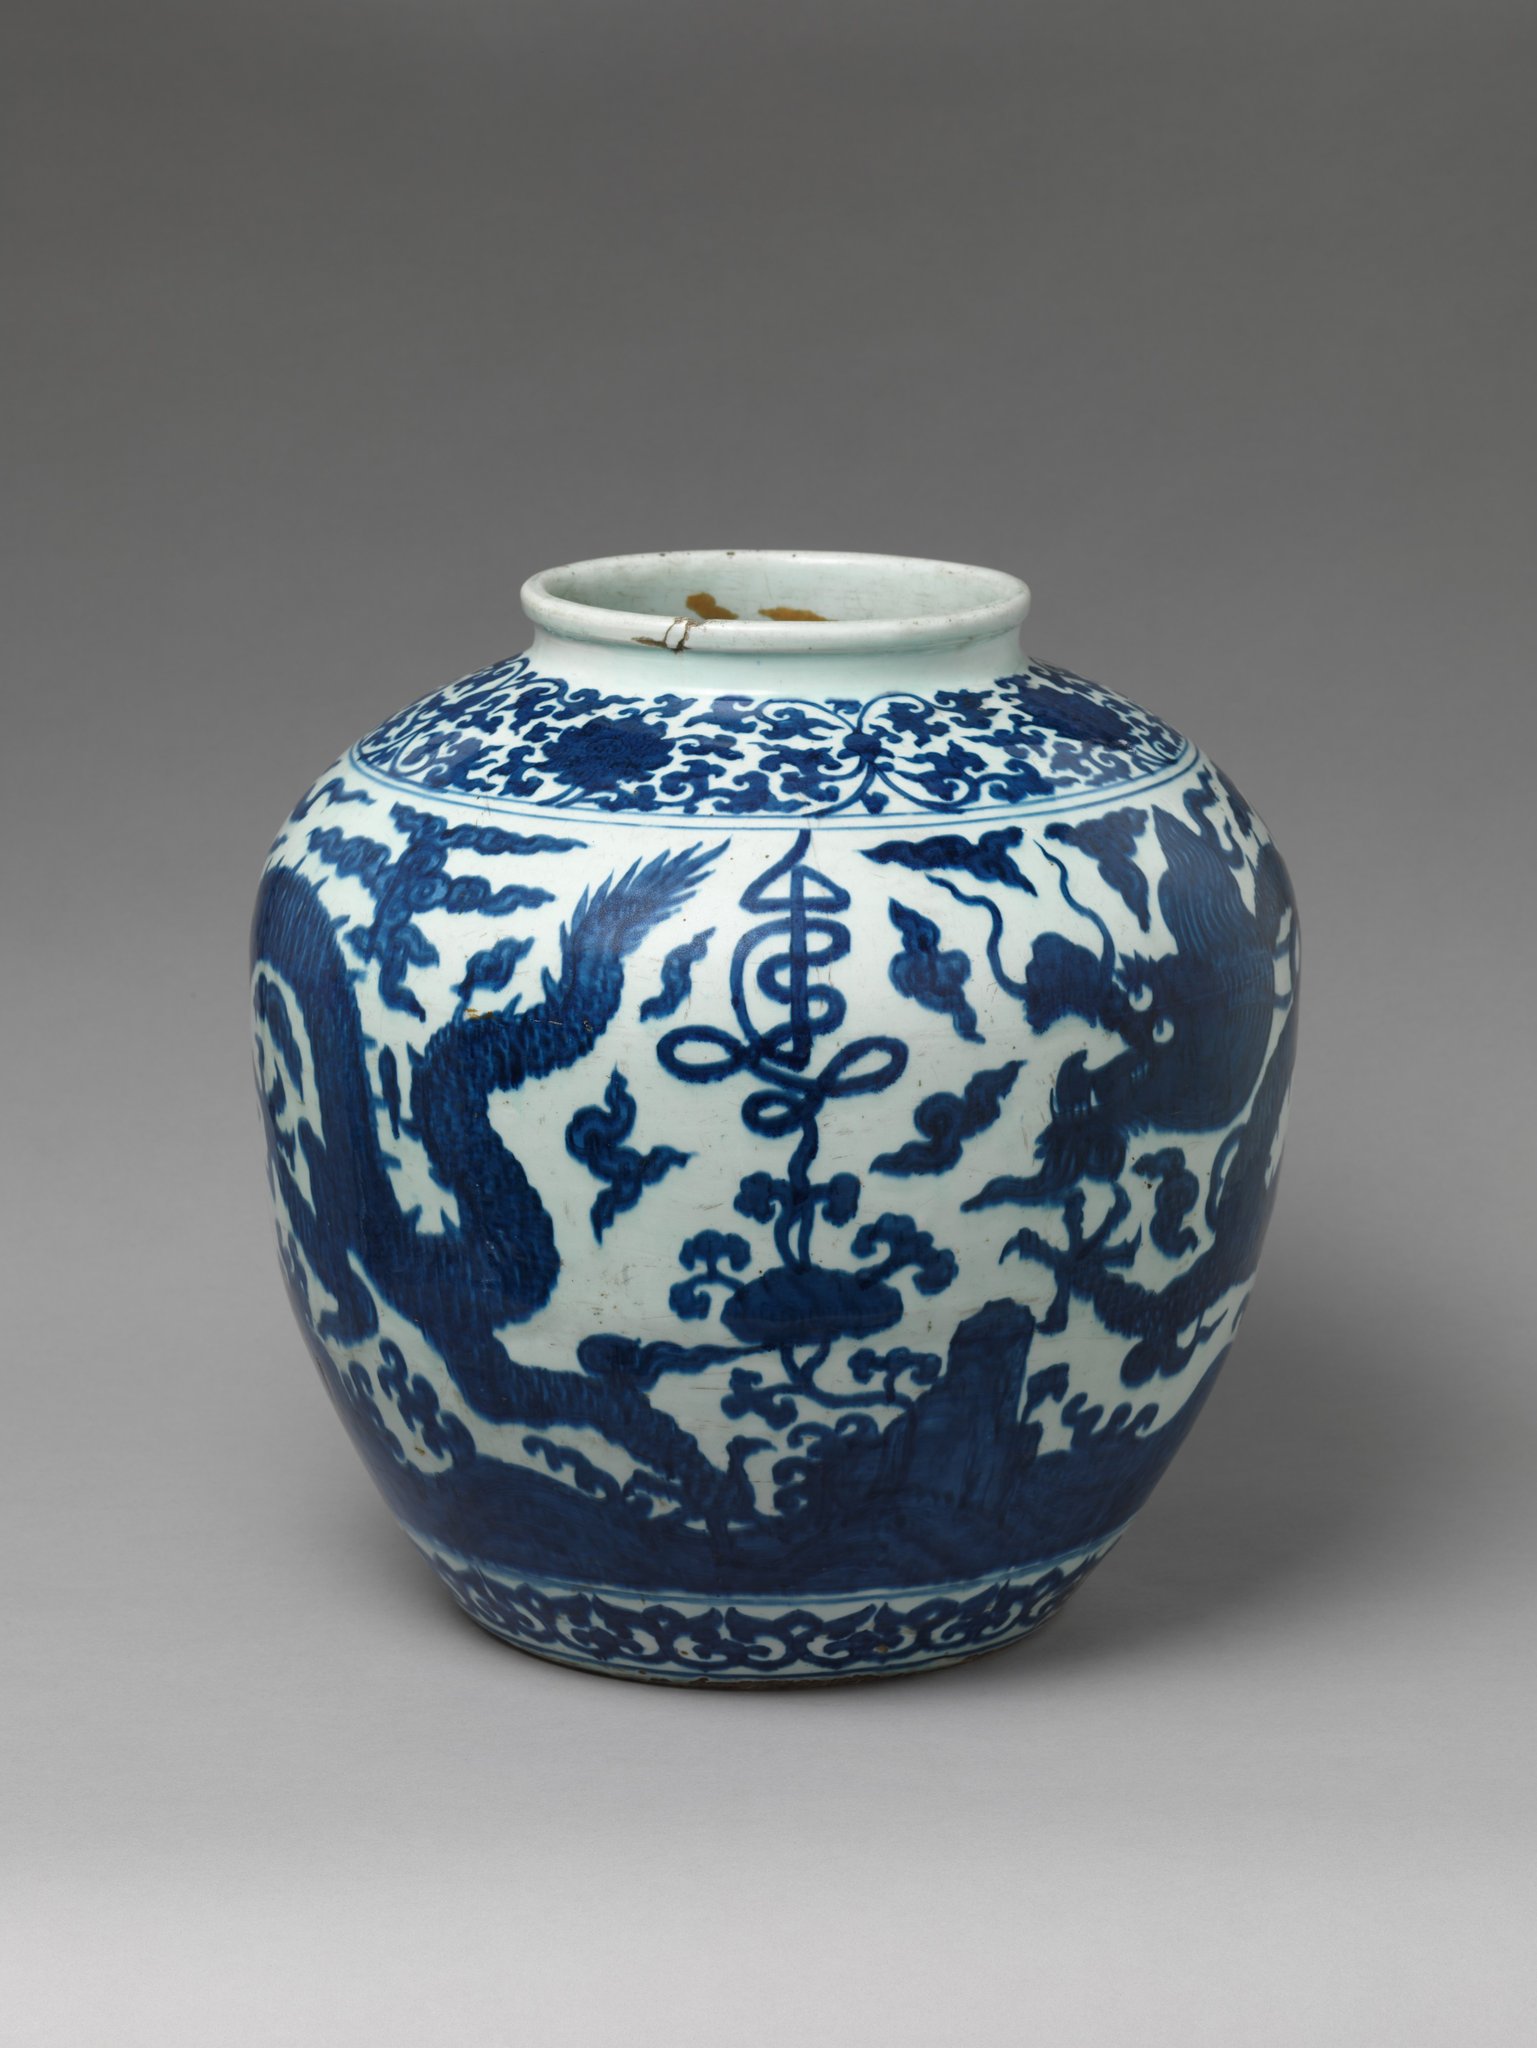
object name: jar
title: Jar with dragon and stylized character for longevity (shou)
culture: chinese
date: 1501-1600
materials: porcelain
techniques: painting, underglaze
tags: dragons